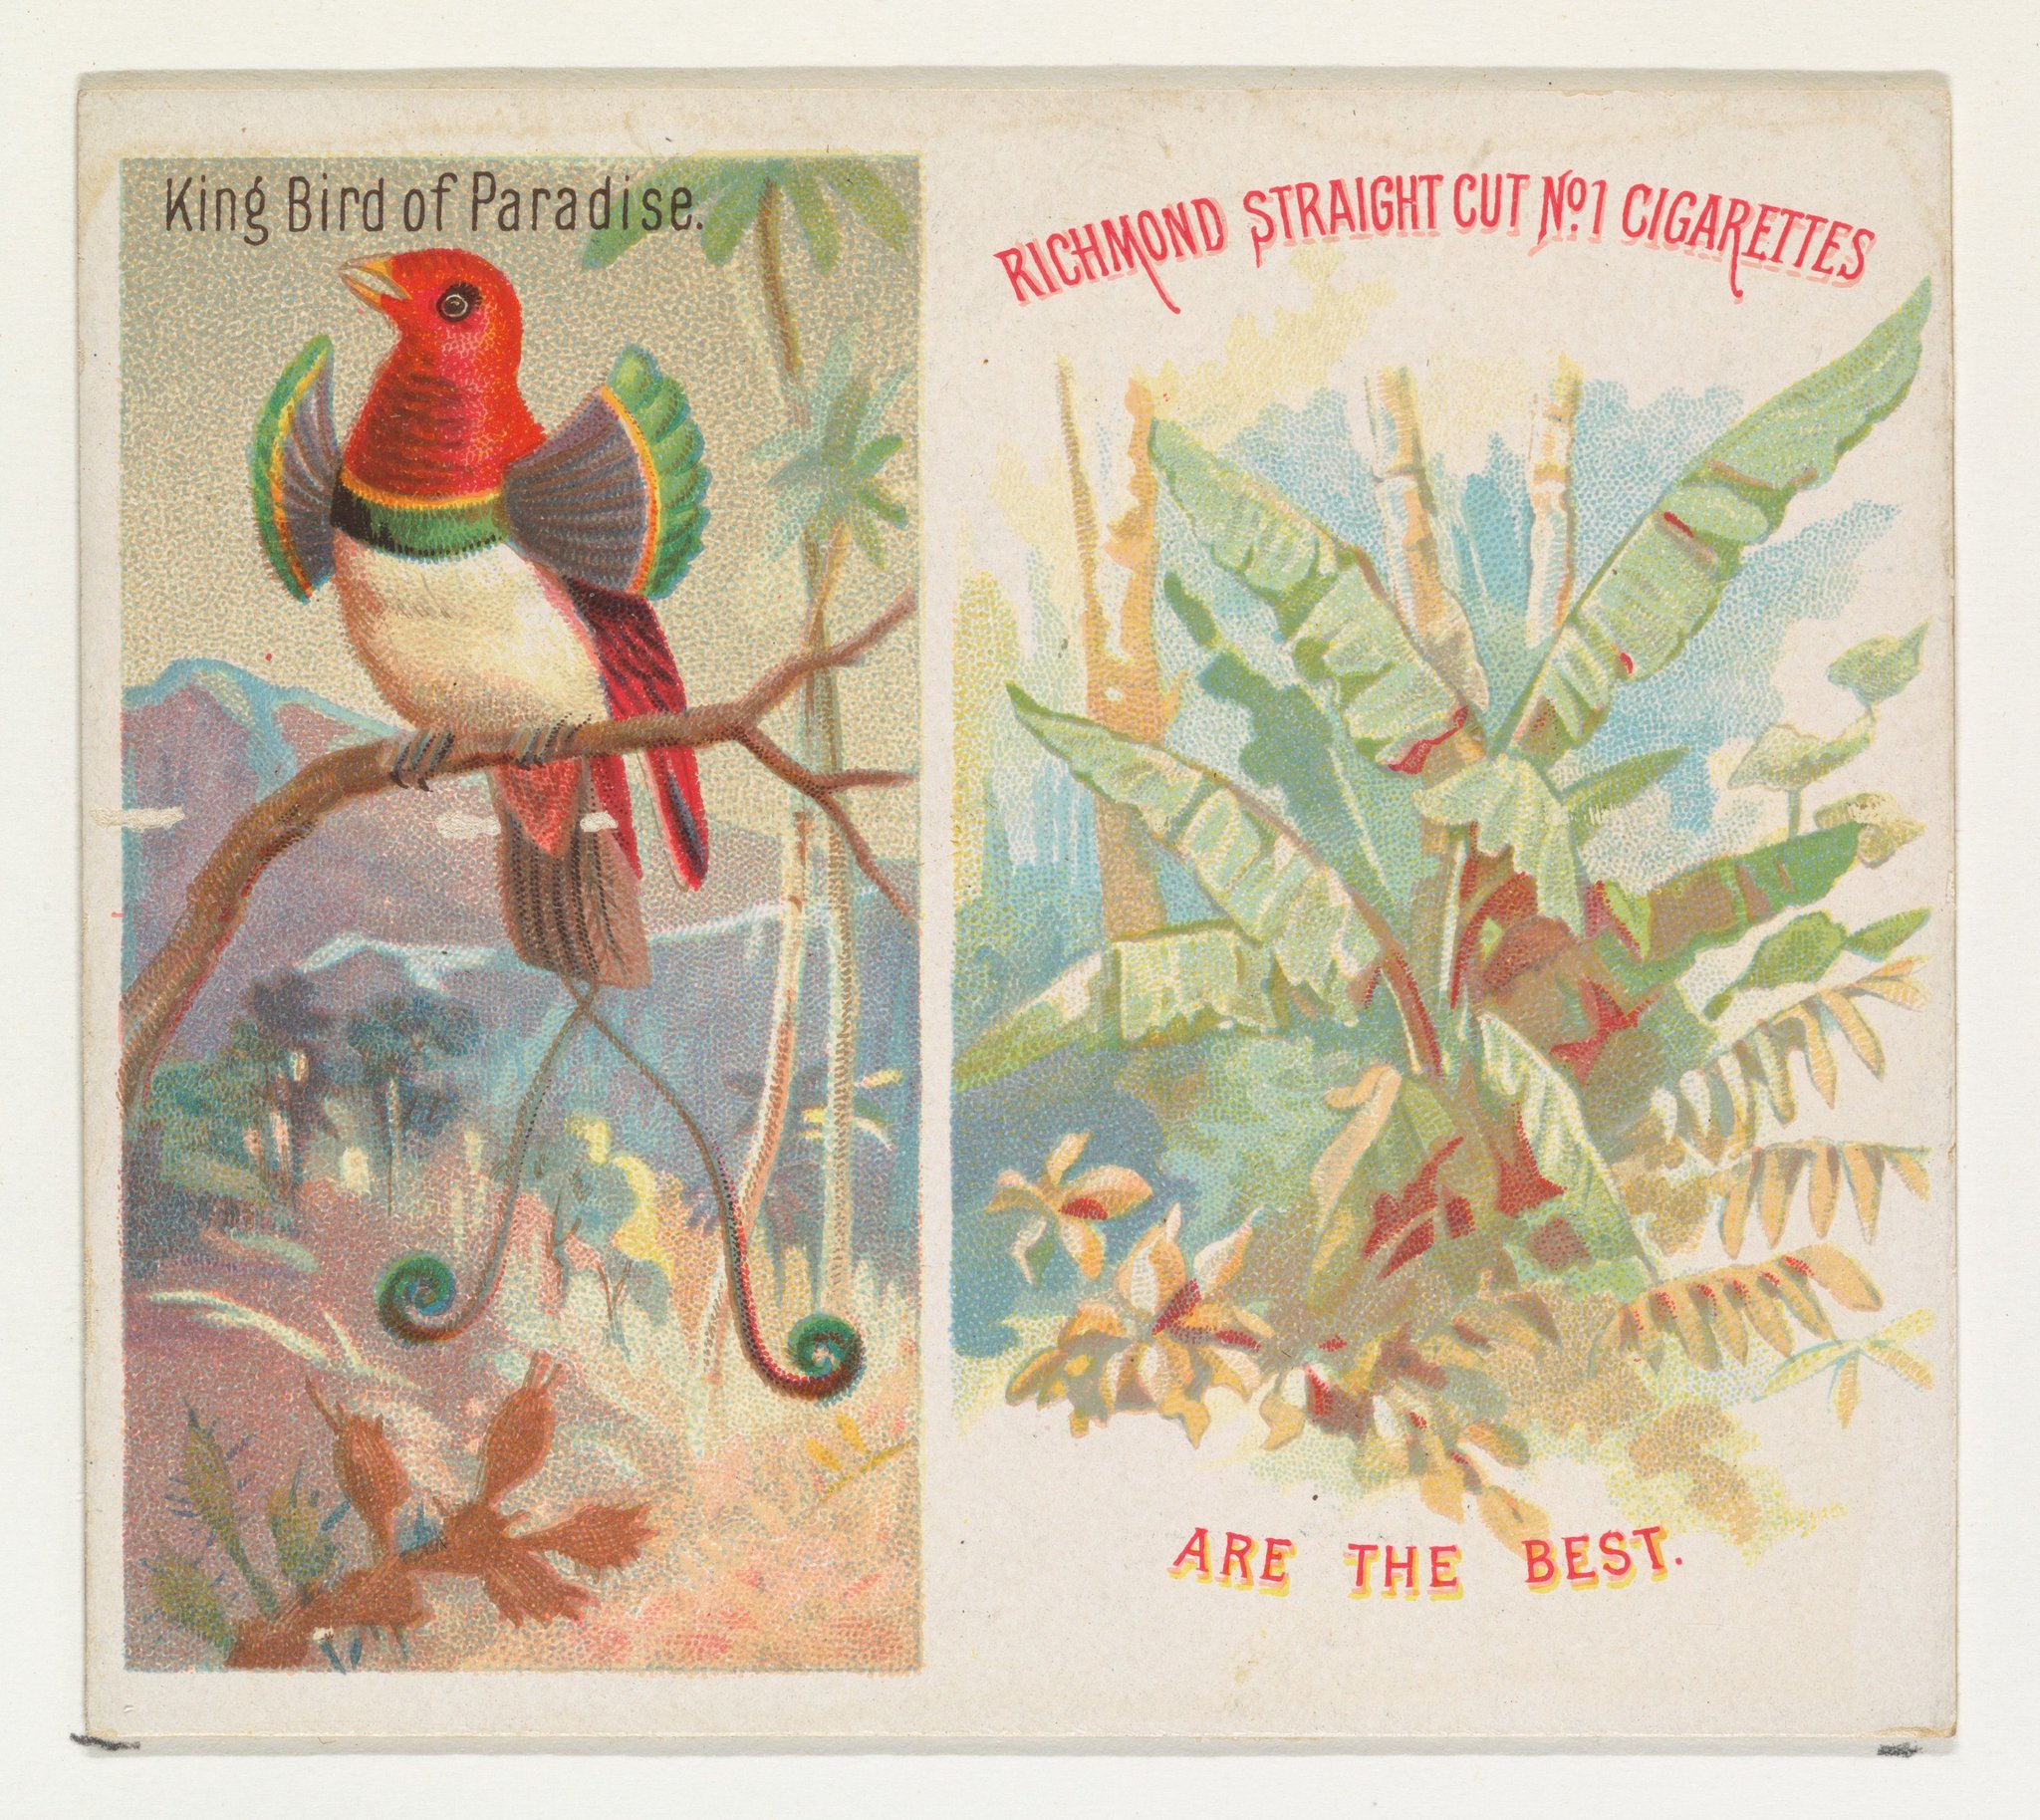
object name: print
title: King Bird of Paradise, from Birds of the Tropics series (N38) for Allen & Ginter Cigarettes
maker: allen & ginter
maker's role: publisher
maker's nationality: american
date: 1889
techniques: color lithograph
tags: birds